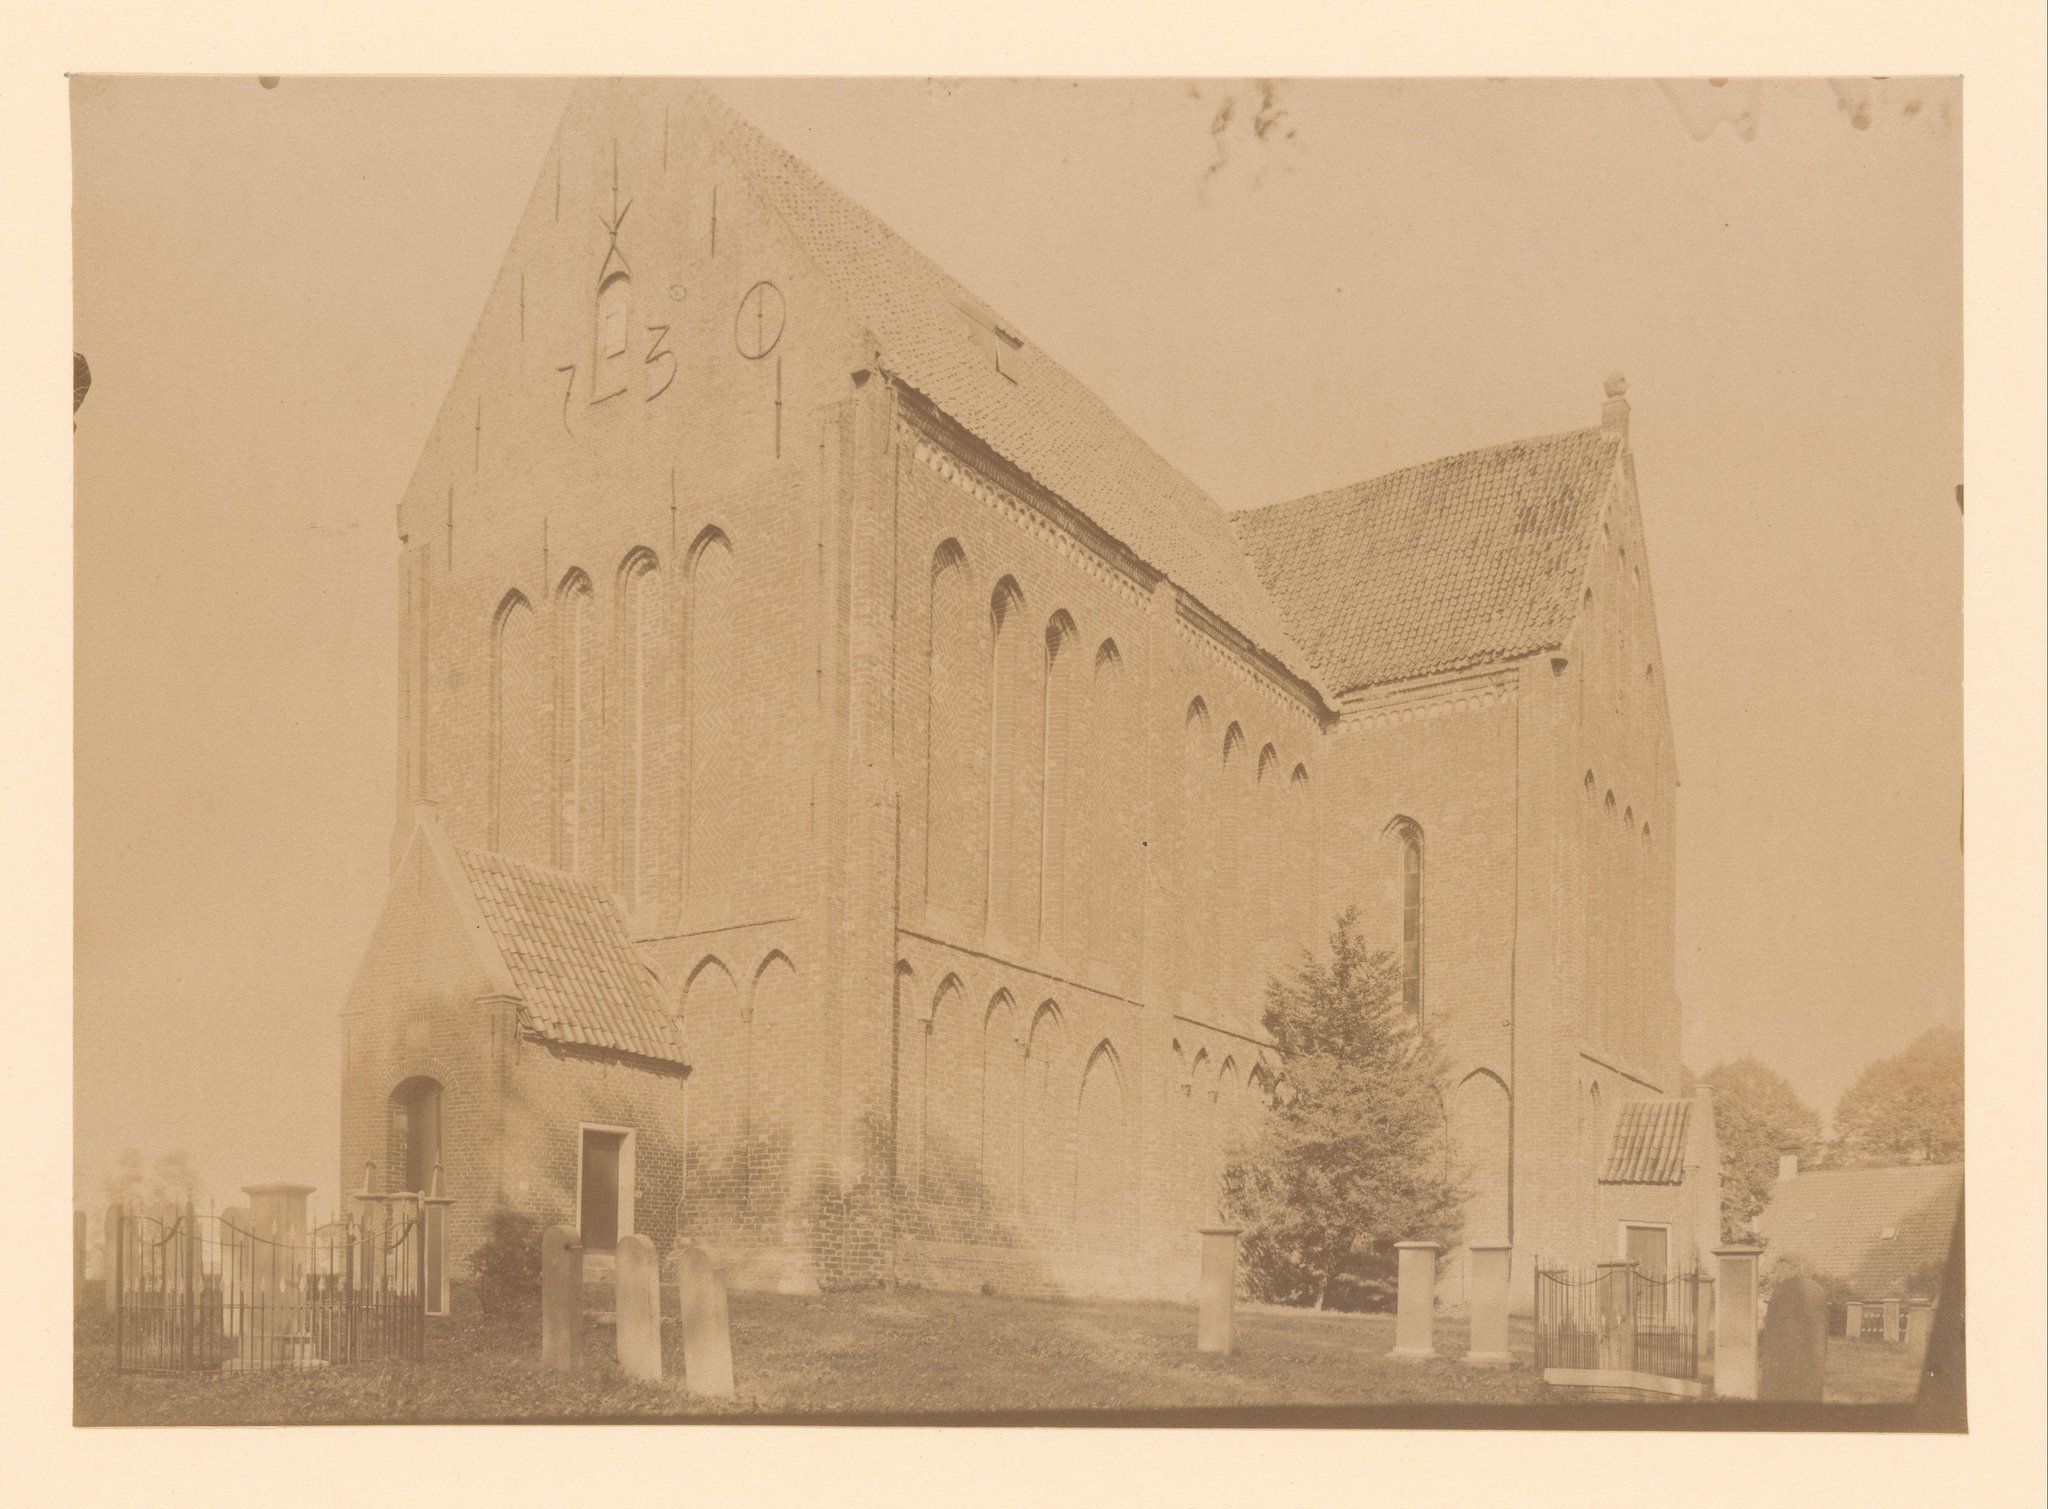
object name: photograph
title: Zuidwestzijde van de Petruskerk te Zuidbroek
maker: anoniem (monumentenzorg)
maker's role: fotograaf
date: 1893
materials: cardboard, photographic support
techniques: albumen print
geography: zuidbroek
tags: church (exterior)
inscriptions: annotation: ‘Zuidbroek/ N.H. kerk gezien van af het zuidwesten/ sept 1893’, annotation: ‘Zuidbroek’